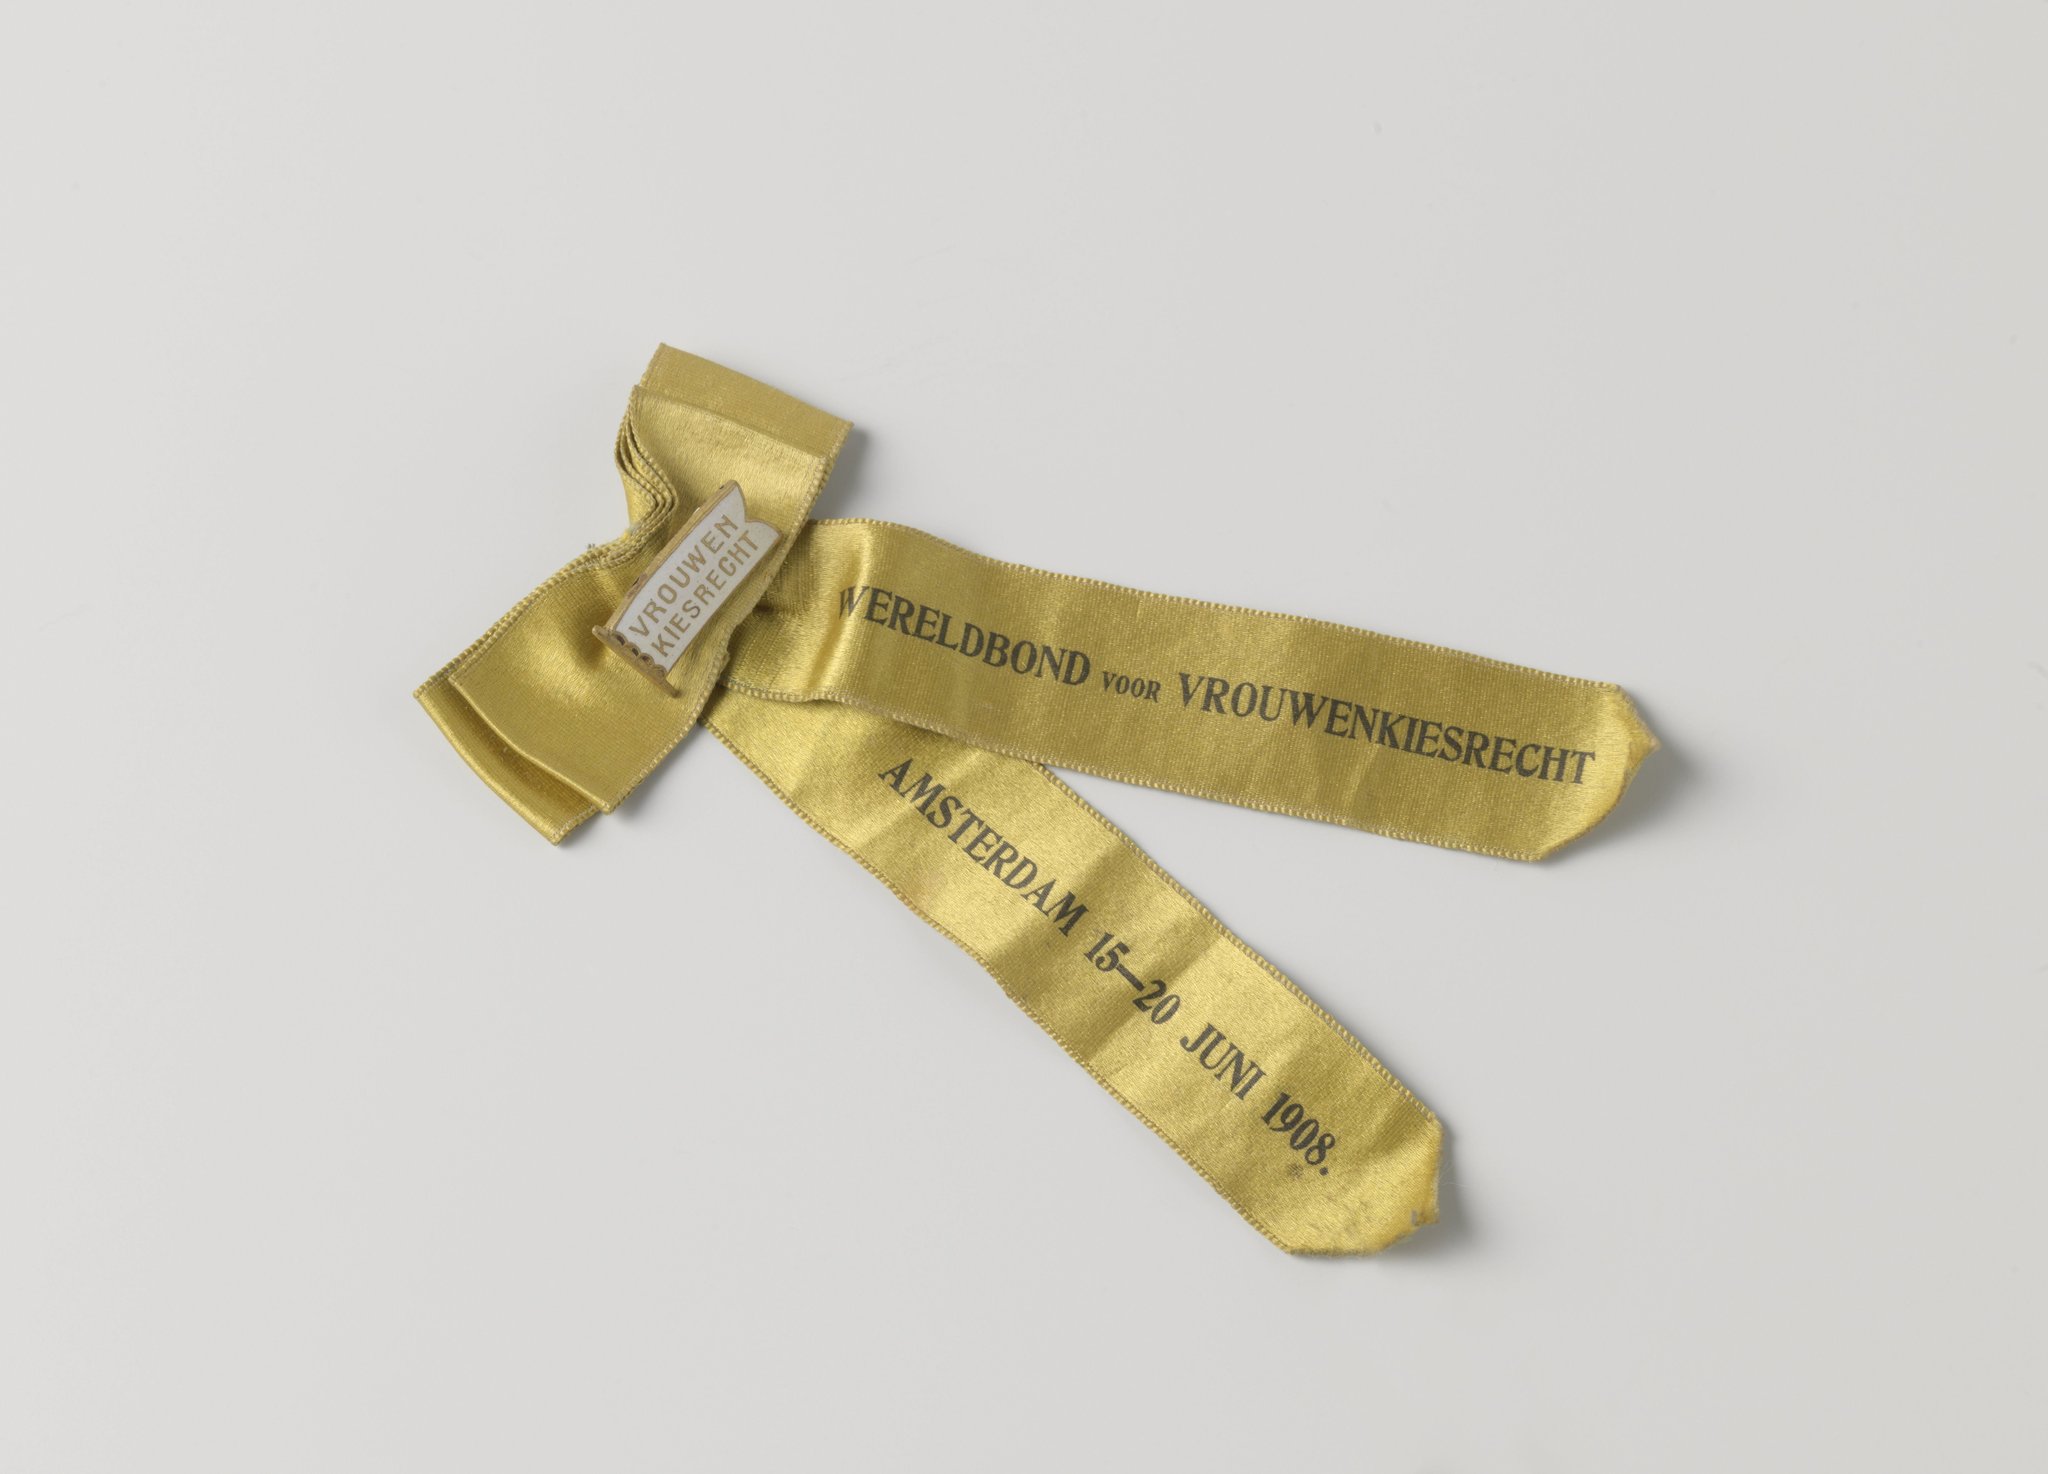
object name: insignia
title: Draaglint vervaardigd voor het vierde internationale Congres van de Wereldbond voor Vrouwenkiesrecht te Amsterdam in 1908 waarop een propagandaspeldje voor vrouwenkiesrecht in Nederland is gemonteerd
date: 1908-1909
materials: copper, metal, silk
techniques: forging, printing, stitching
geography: netherlands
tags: netherlands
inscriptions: date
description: Geel zijden strik, aan de achterzijde bijeengehouden met een veiligheidsspeld. Op de twee afhangende linten bedrukt met tekst in zwart. Op de strik van het lint is later een geëmailleerd speldje gemonteerd met het opschrift VROUWEN KIESRECHT. In een wit kartonnen doosje opgeborgen. Gedateerd op het afhangende lint: AMSTERDAM 15 - 20 JUNI 1908 en op het andere lint de tekst WERELDBOND VOOR VROUWENKIESRECHT.